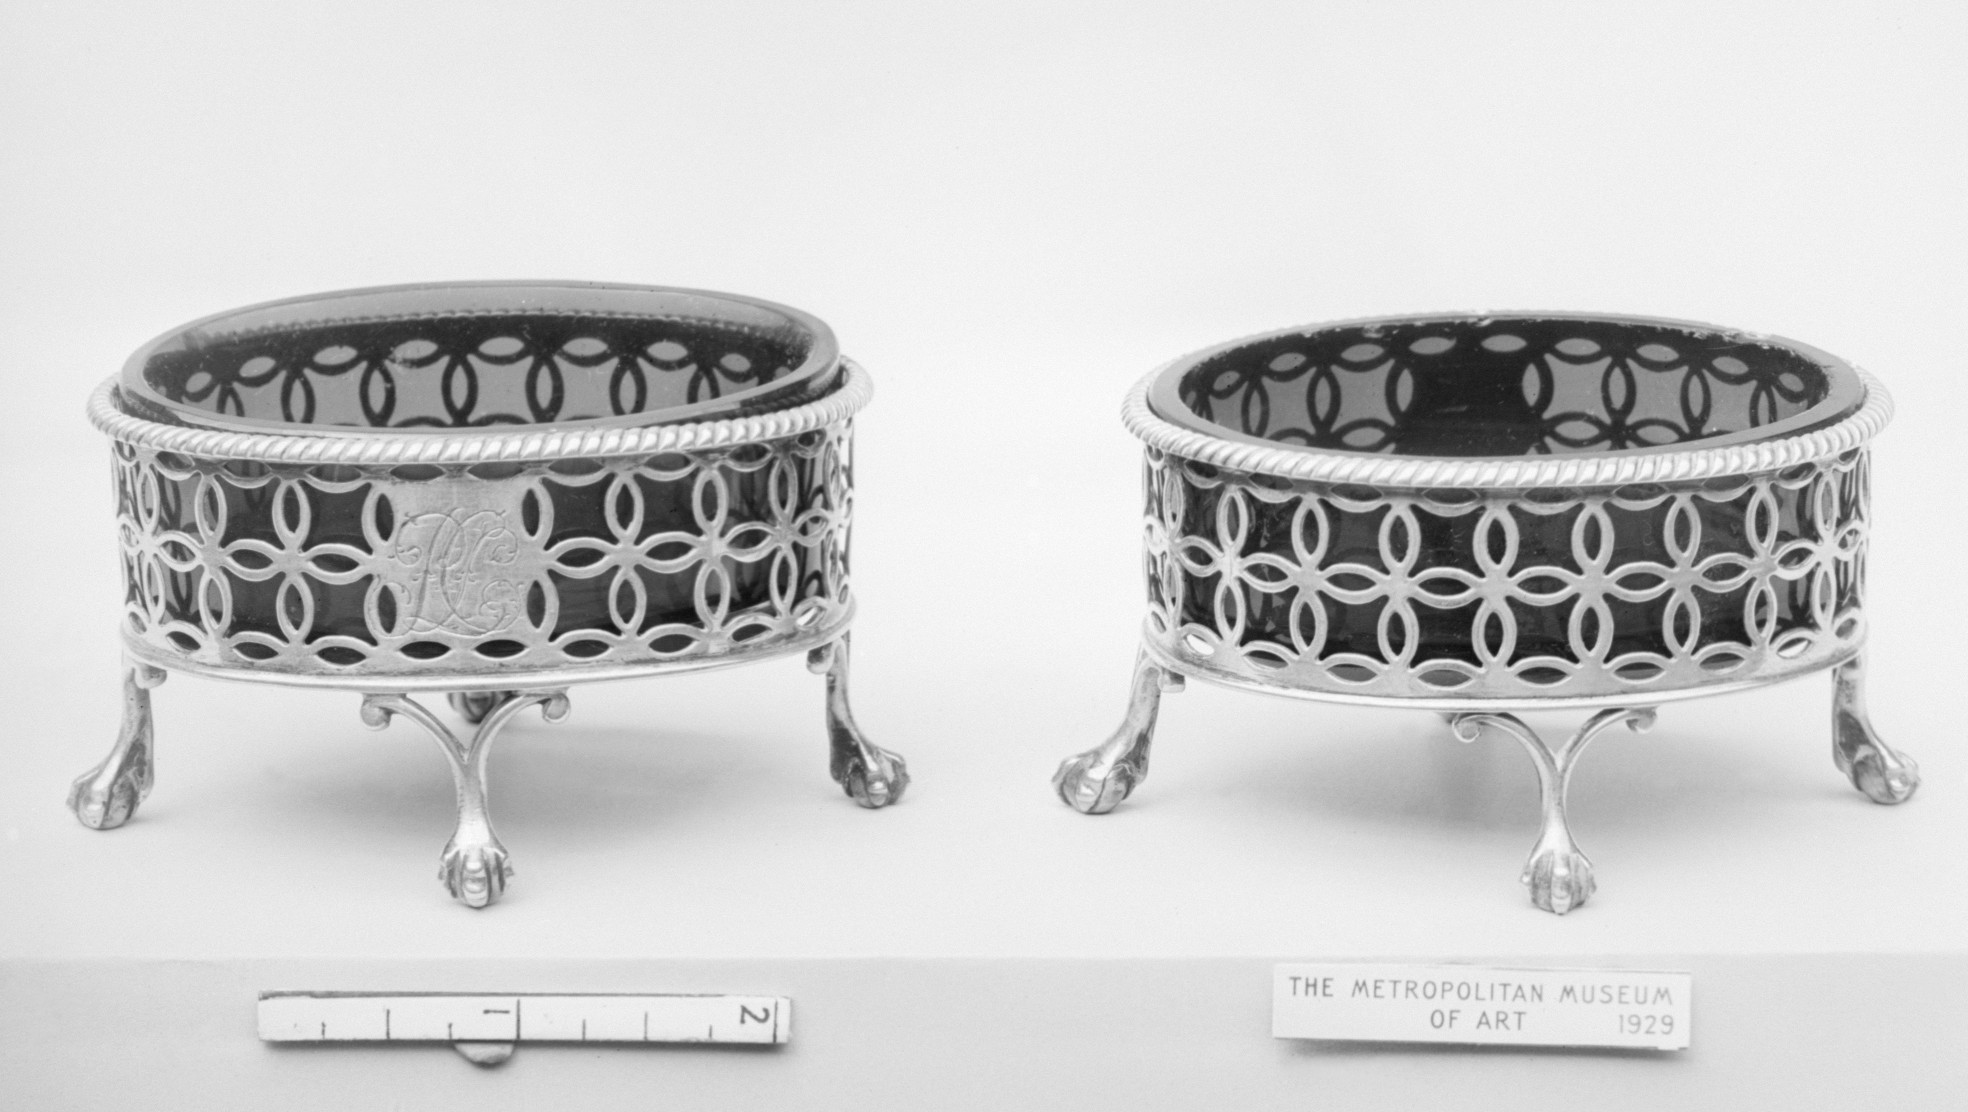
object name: saltcellar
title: Pair of saltcellars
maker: edward lowe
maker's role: maker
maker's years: 1769-1778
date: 1771-1772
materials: glass, silver